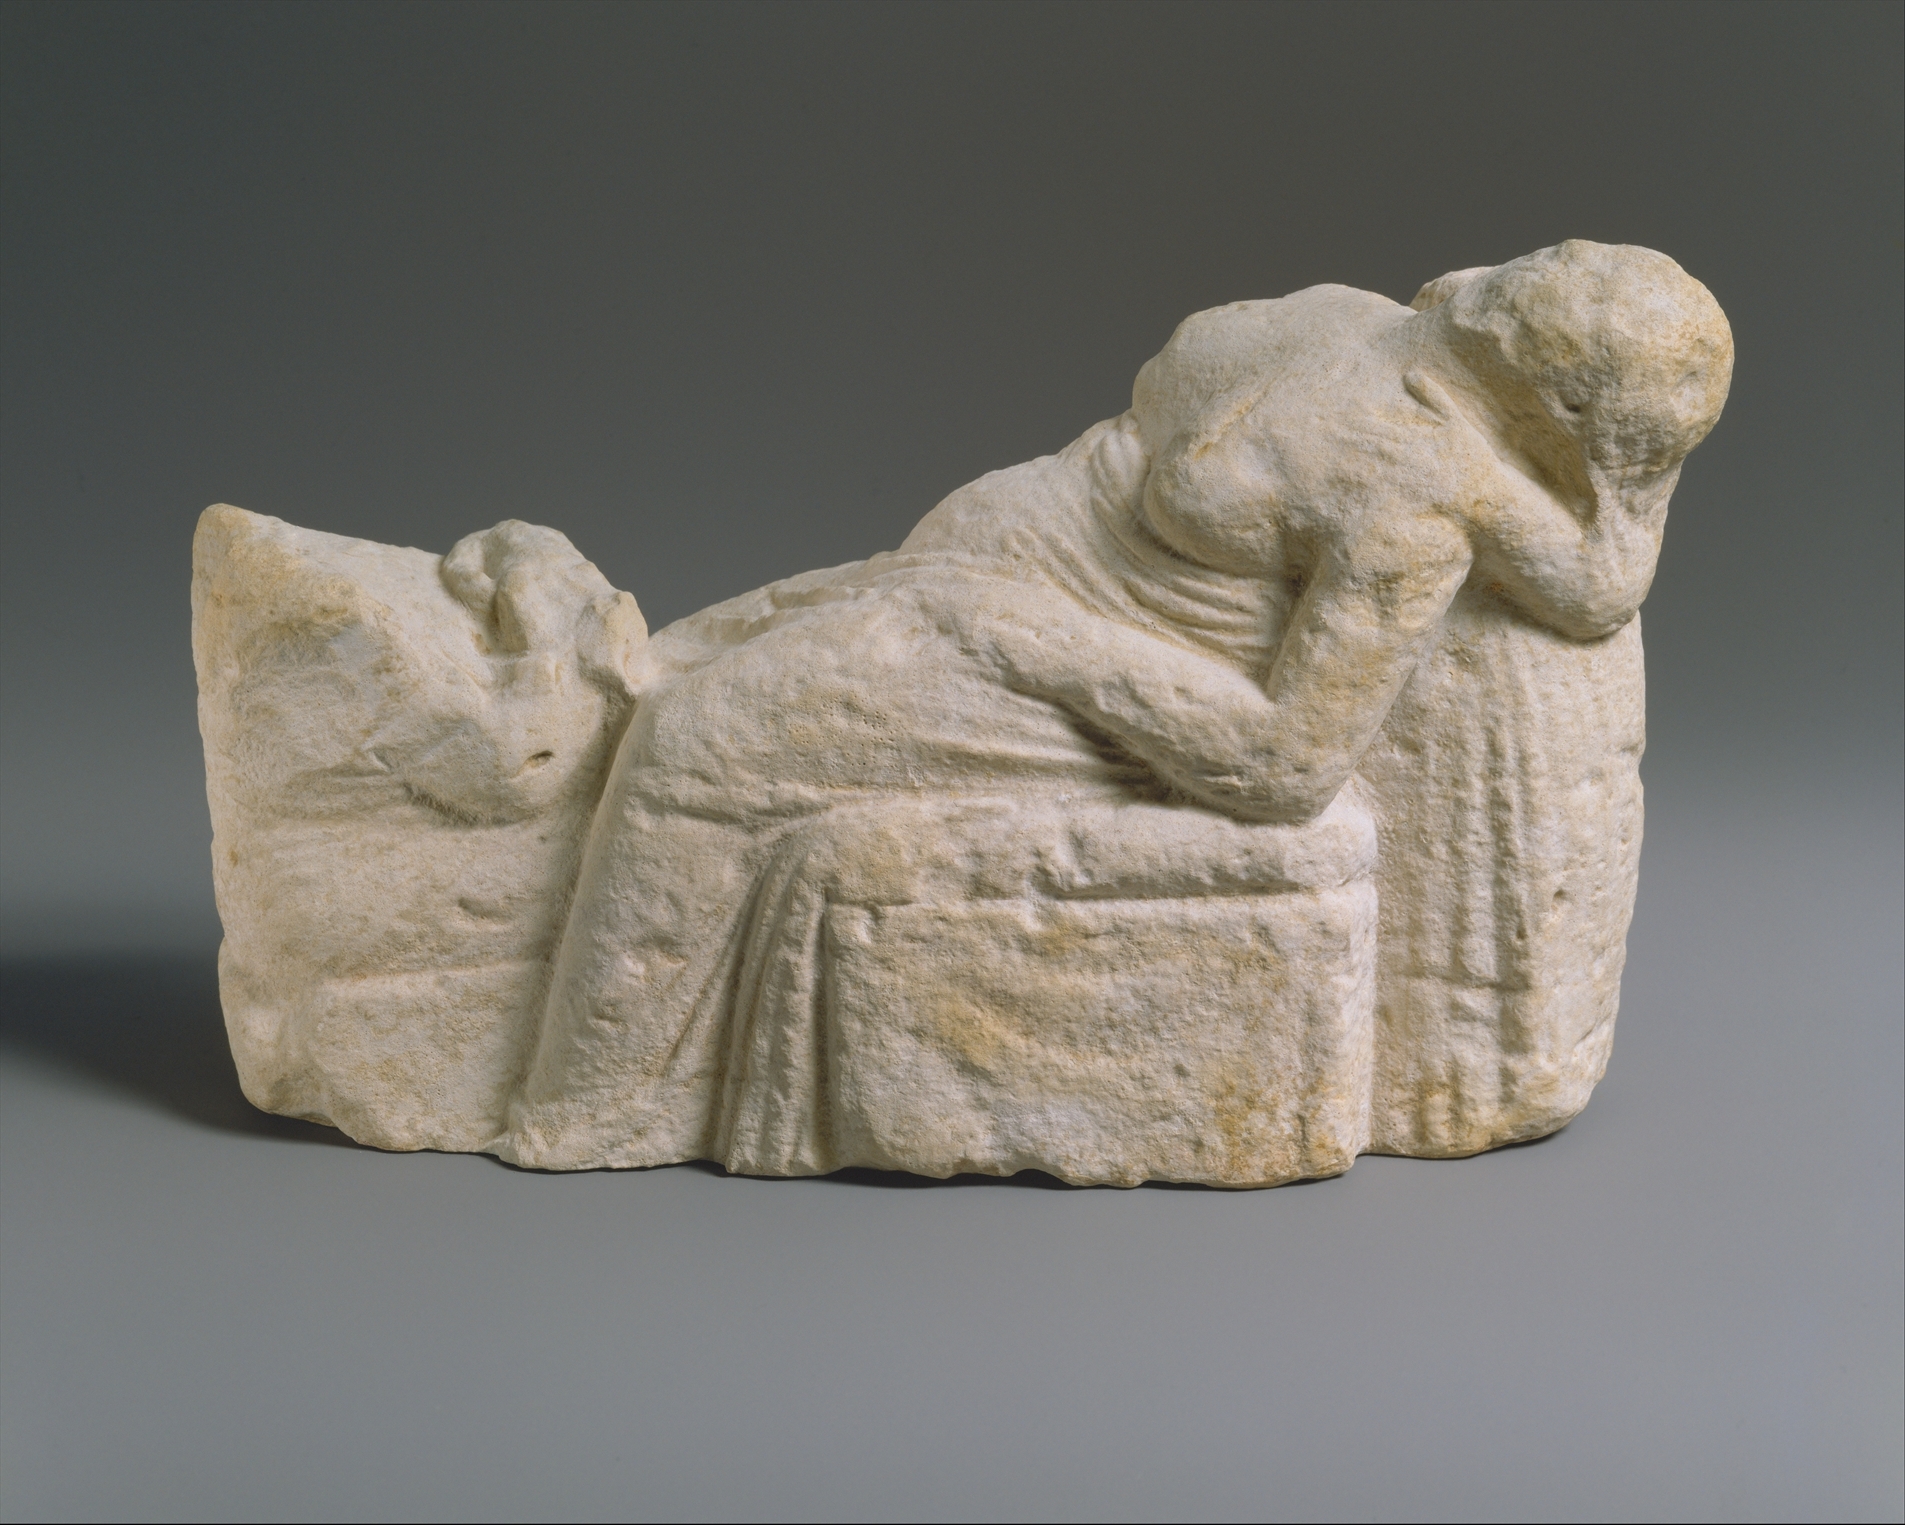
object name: statuette of a childbirth scene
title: Limestone statuette of a childbirth scene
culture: cypriot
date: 310-30 BCE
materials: limestone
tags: women,birth